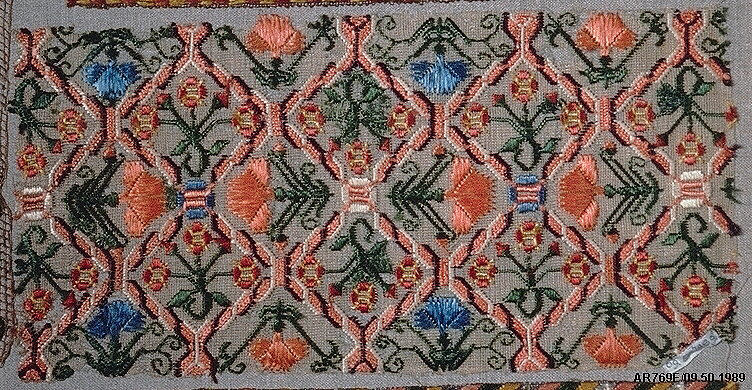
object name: fragment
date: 1801-1900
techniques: embroidery